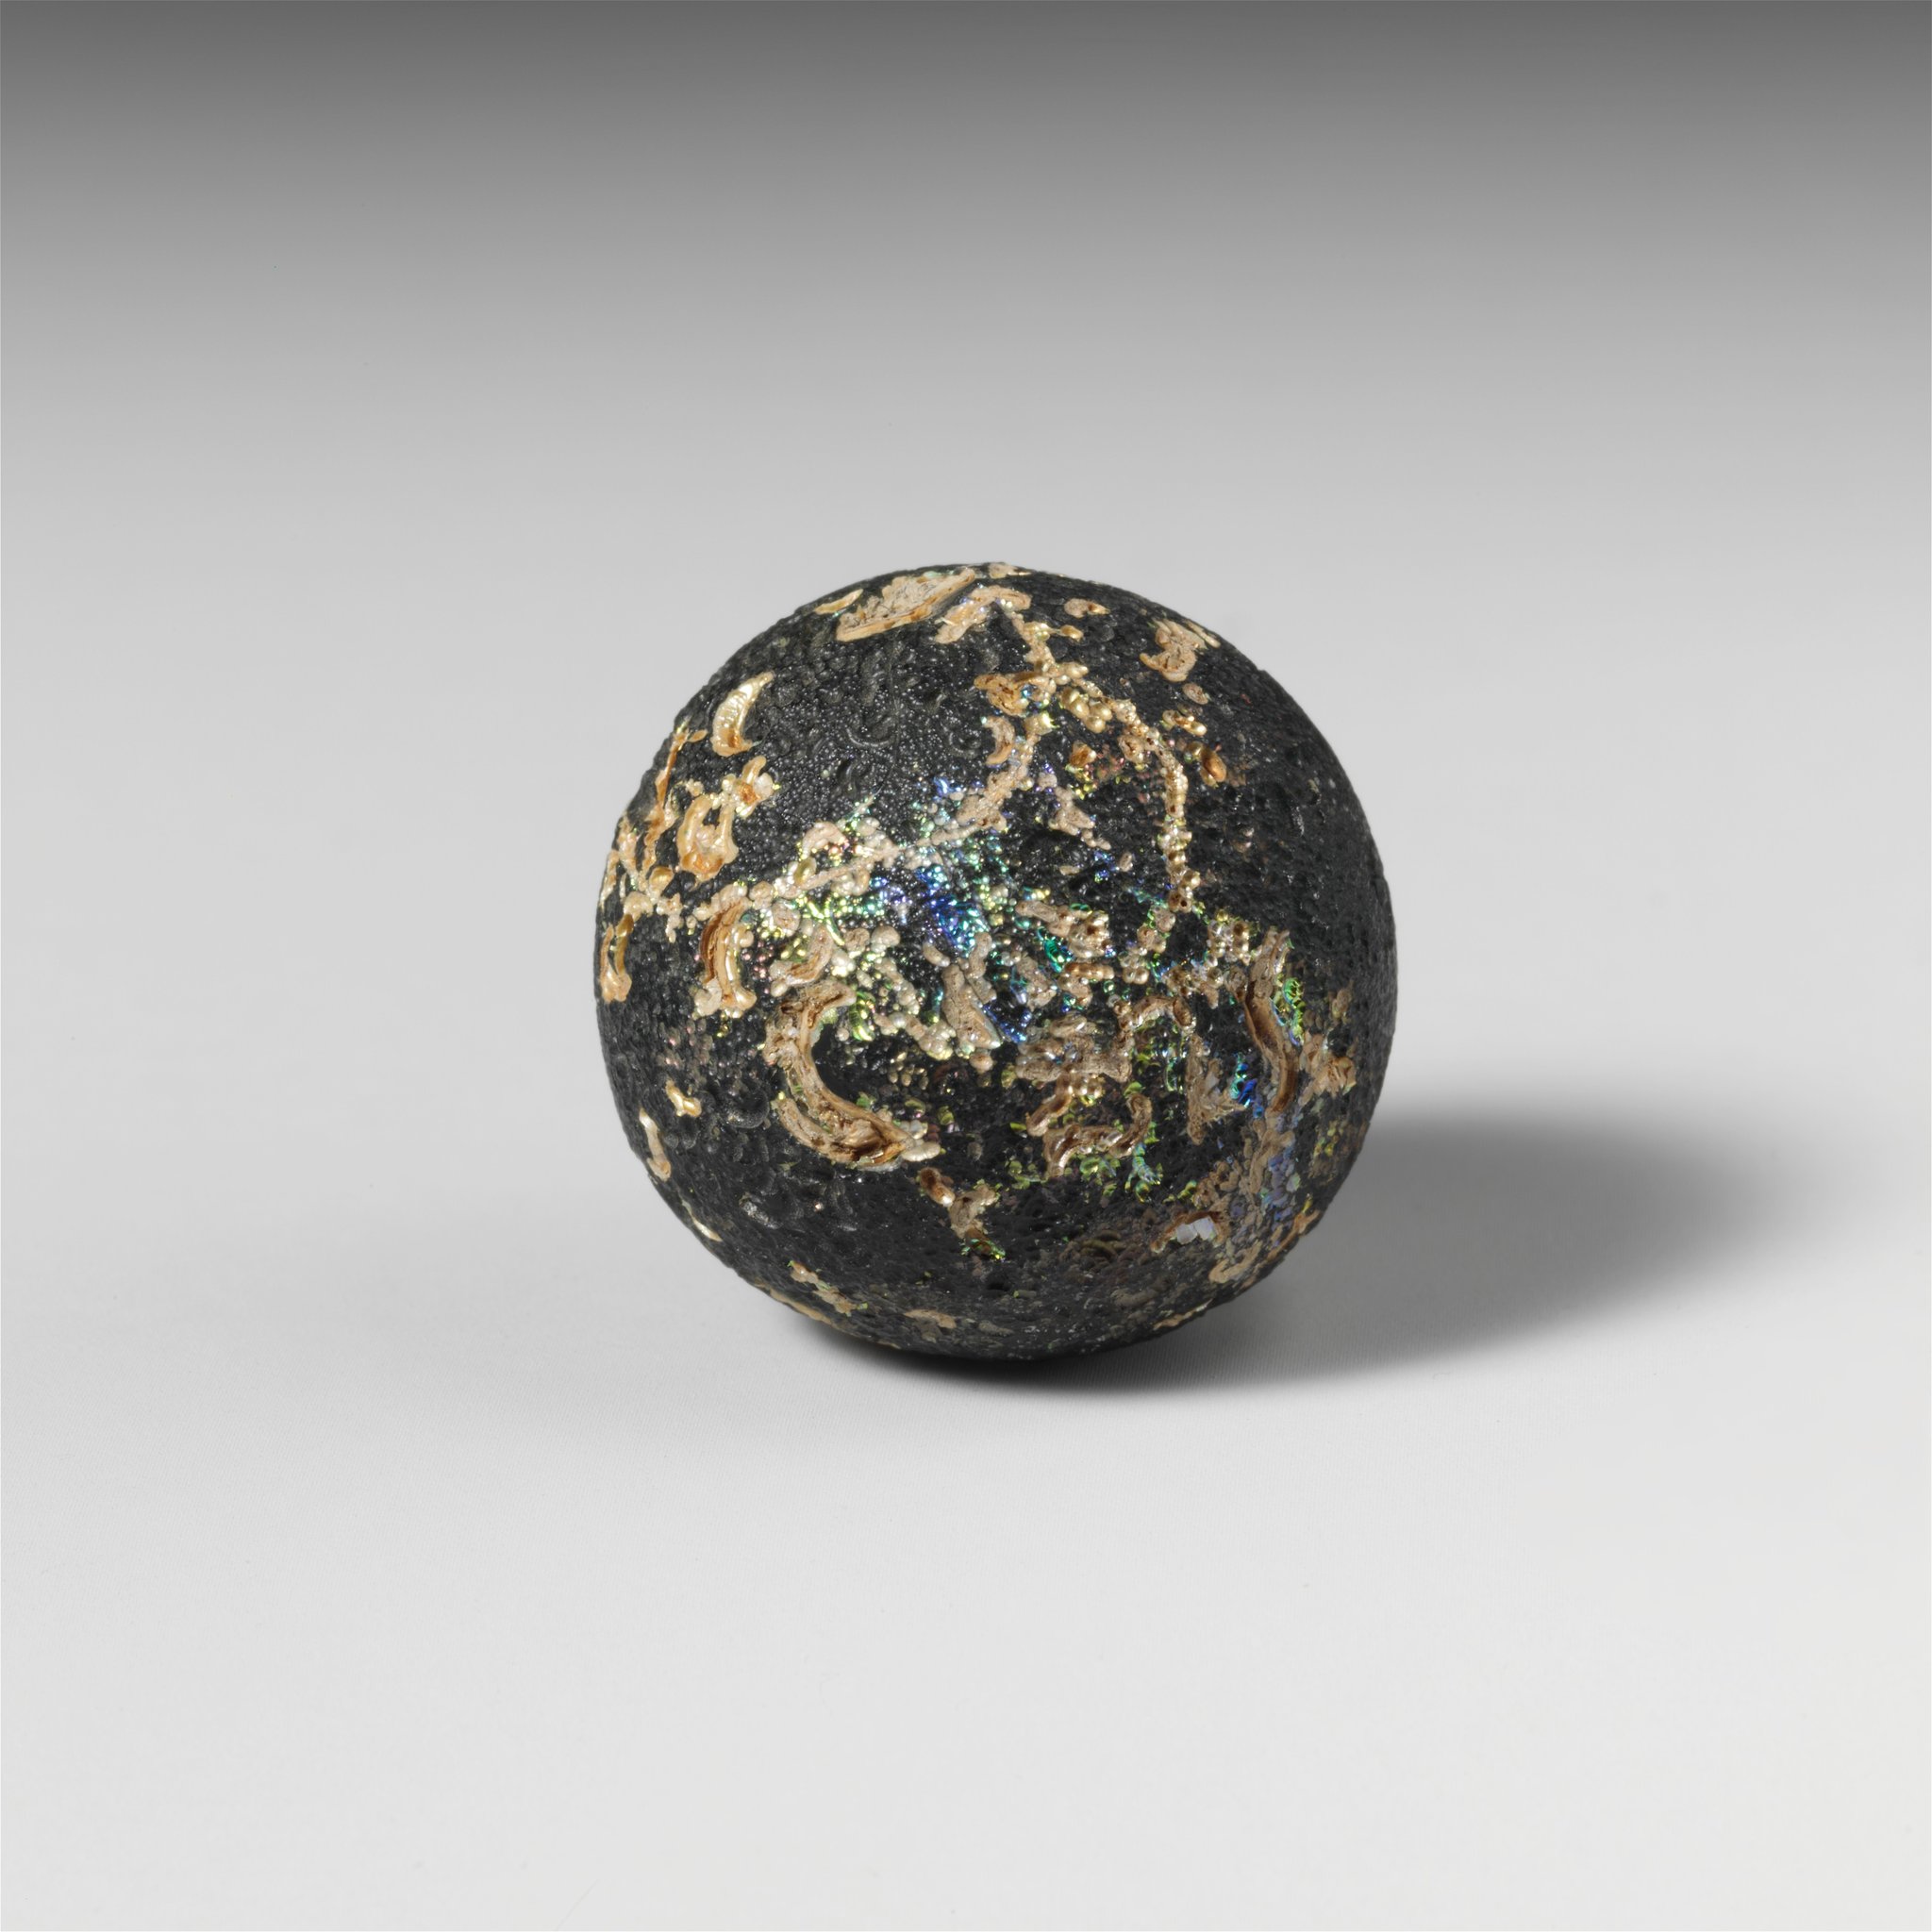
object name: ball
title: Glass marble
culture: roman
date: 1-400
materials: glass